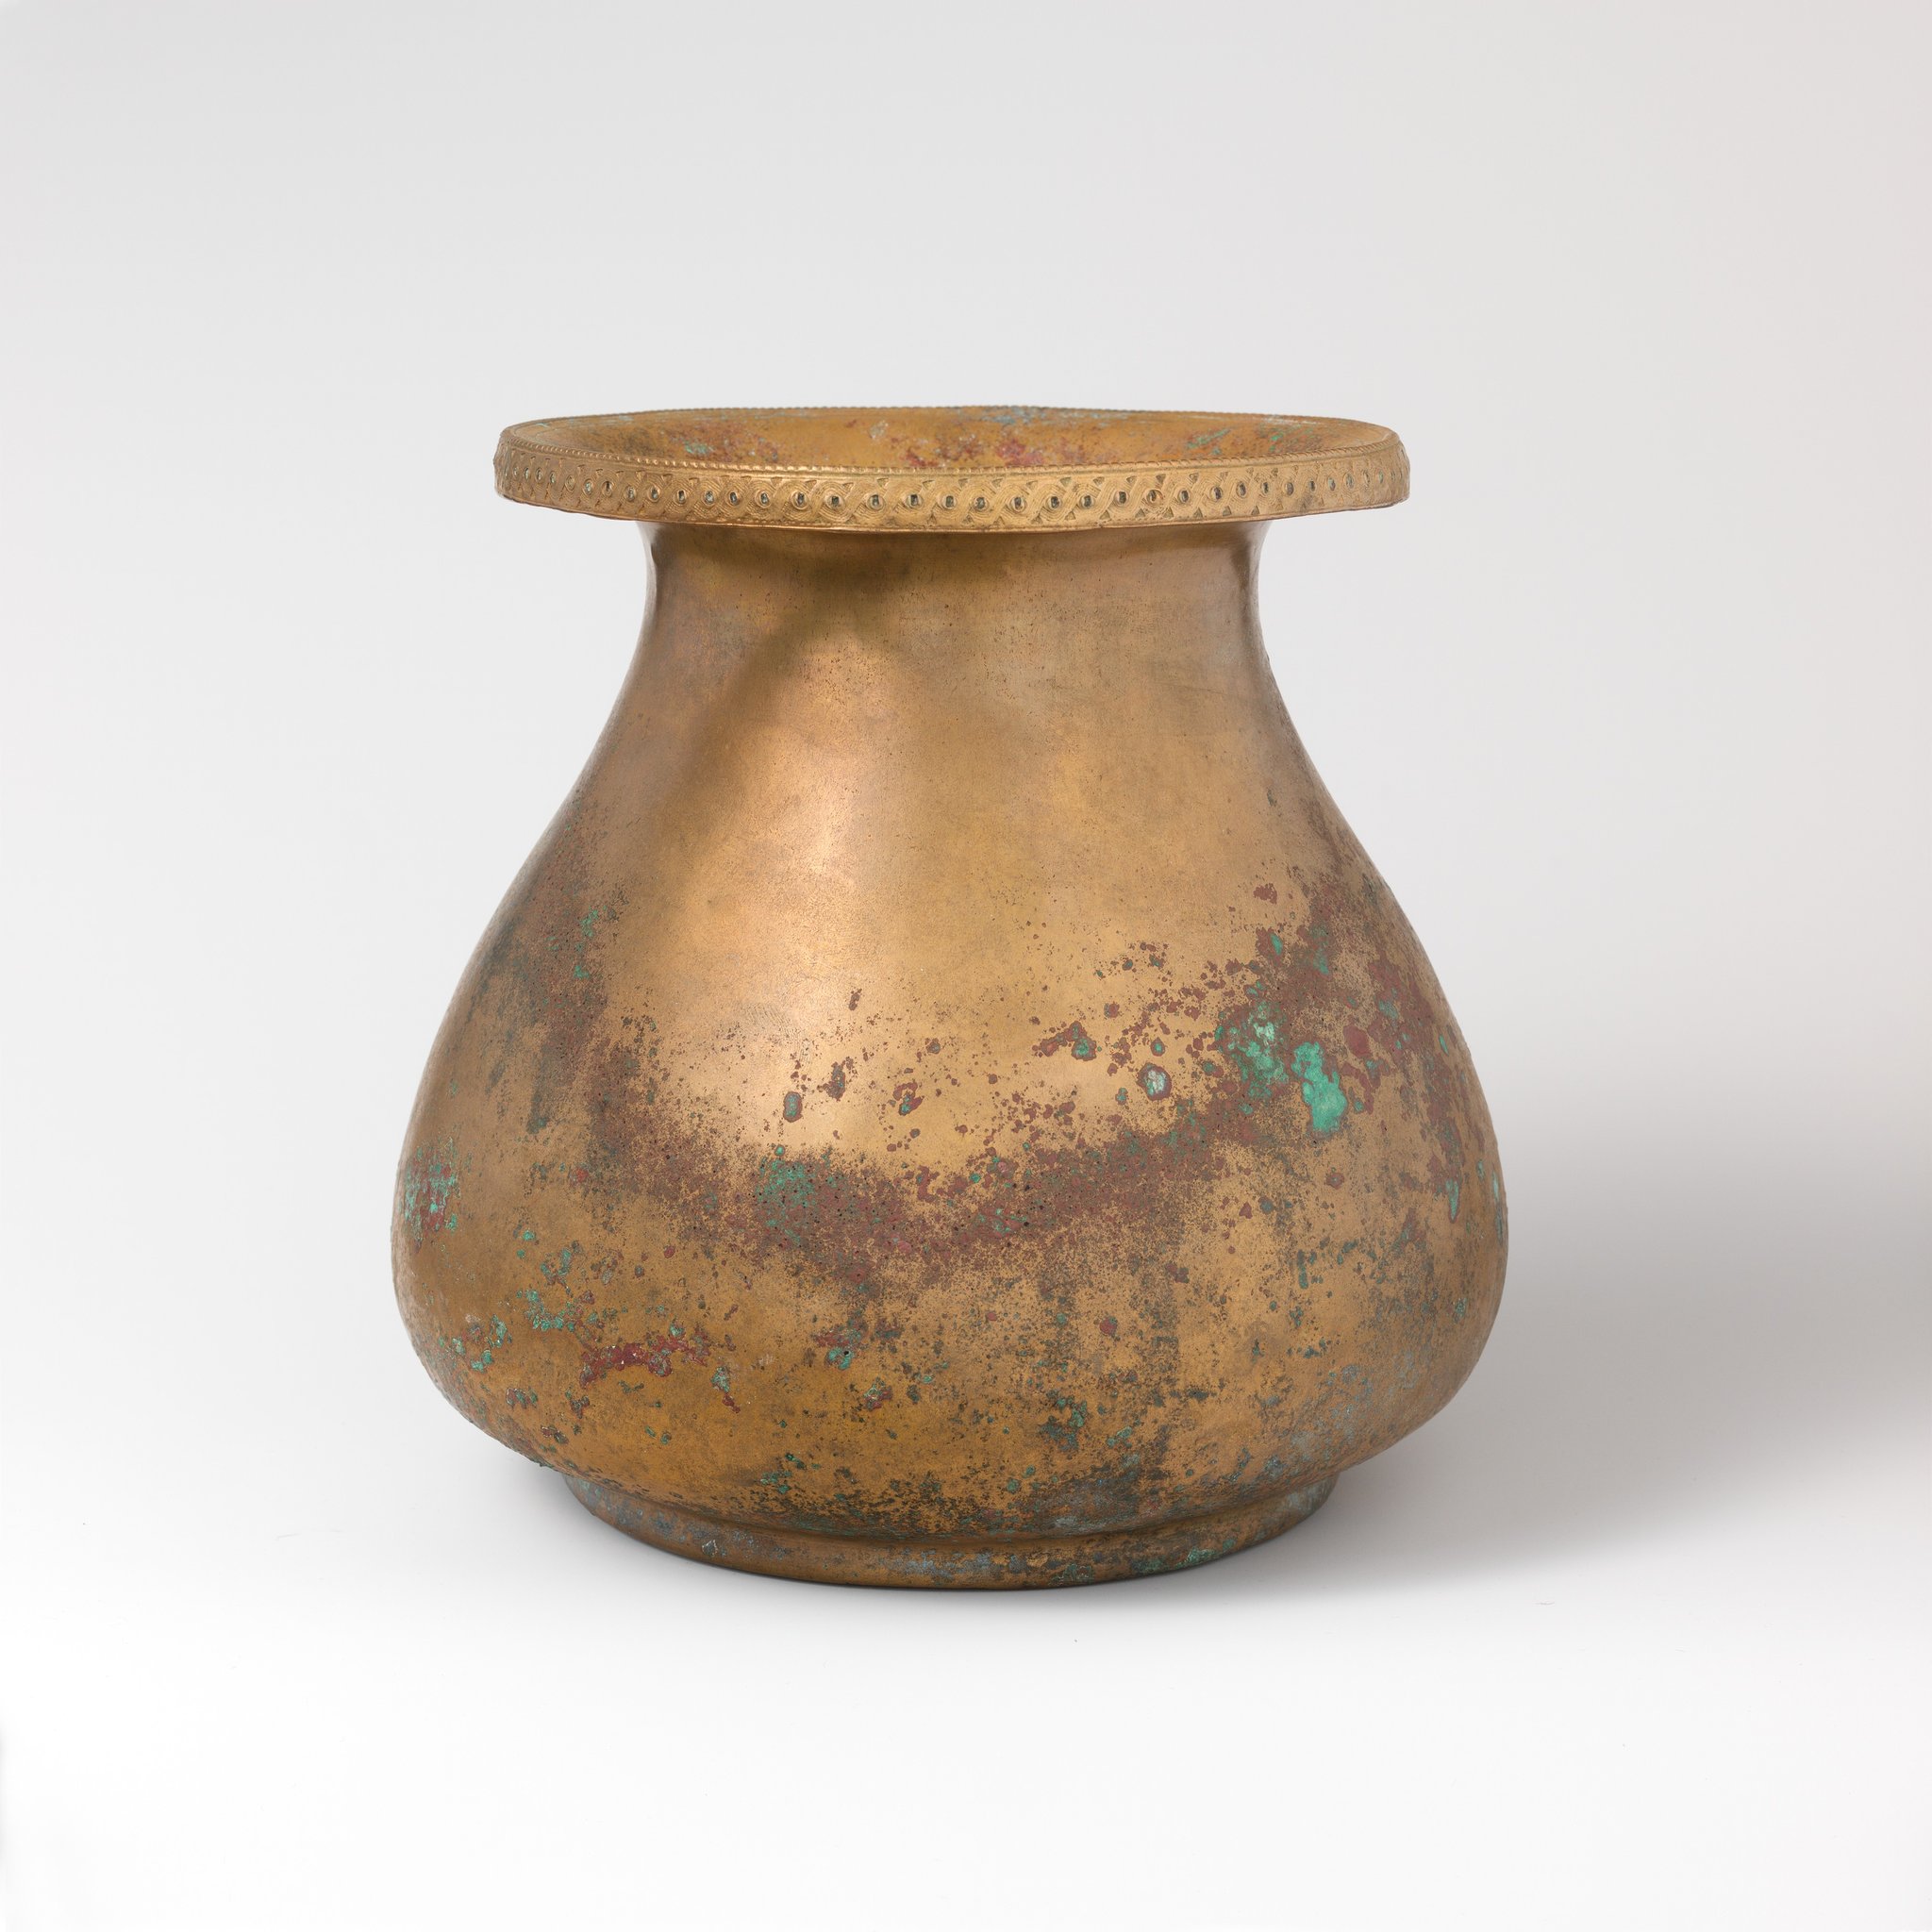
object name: jug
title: Bronze jug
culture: roman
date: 1-100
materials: bronze